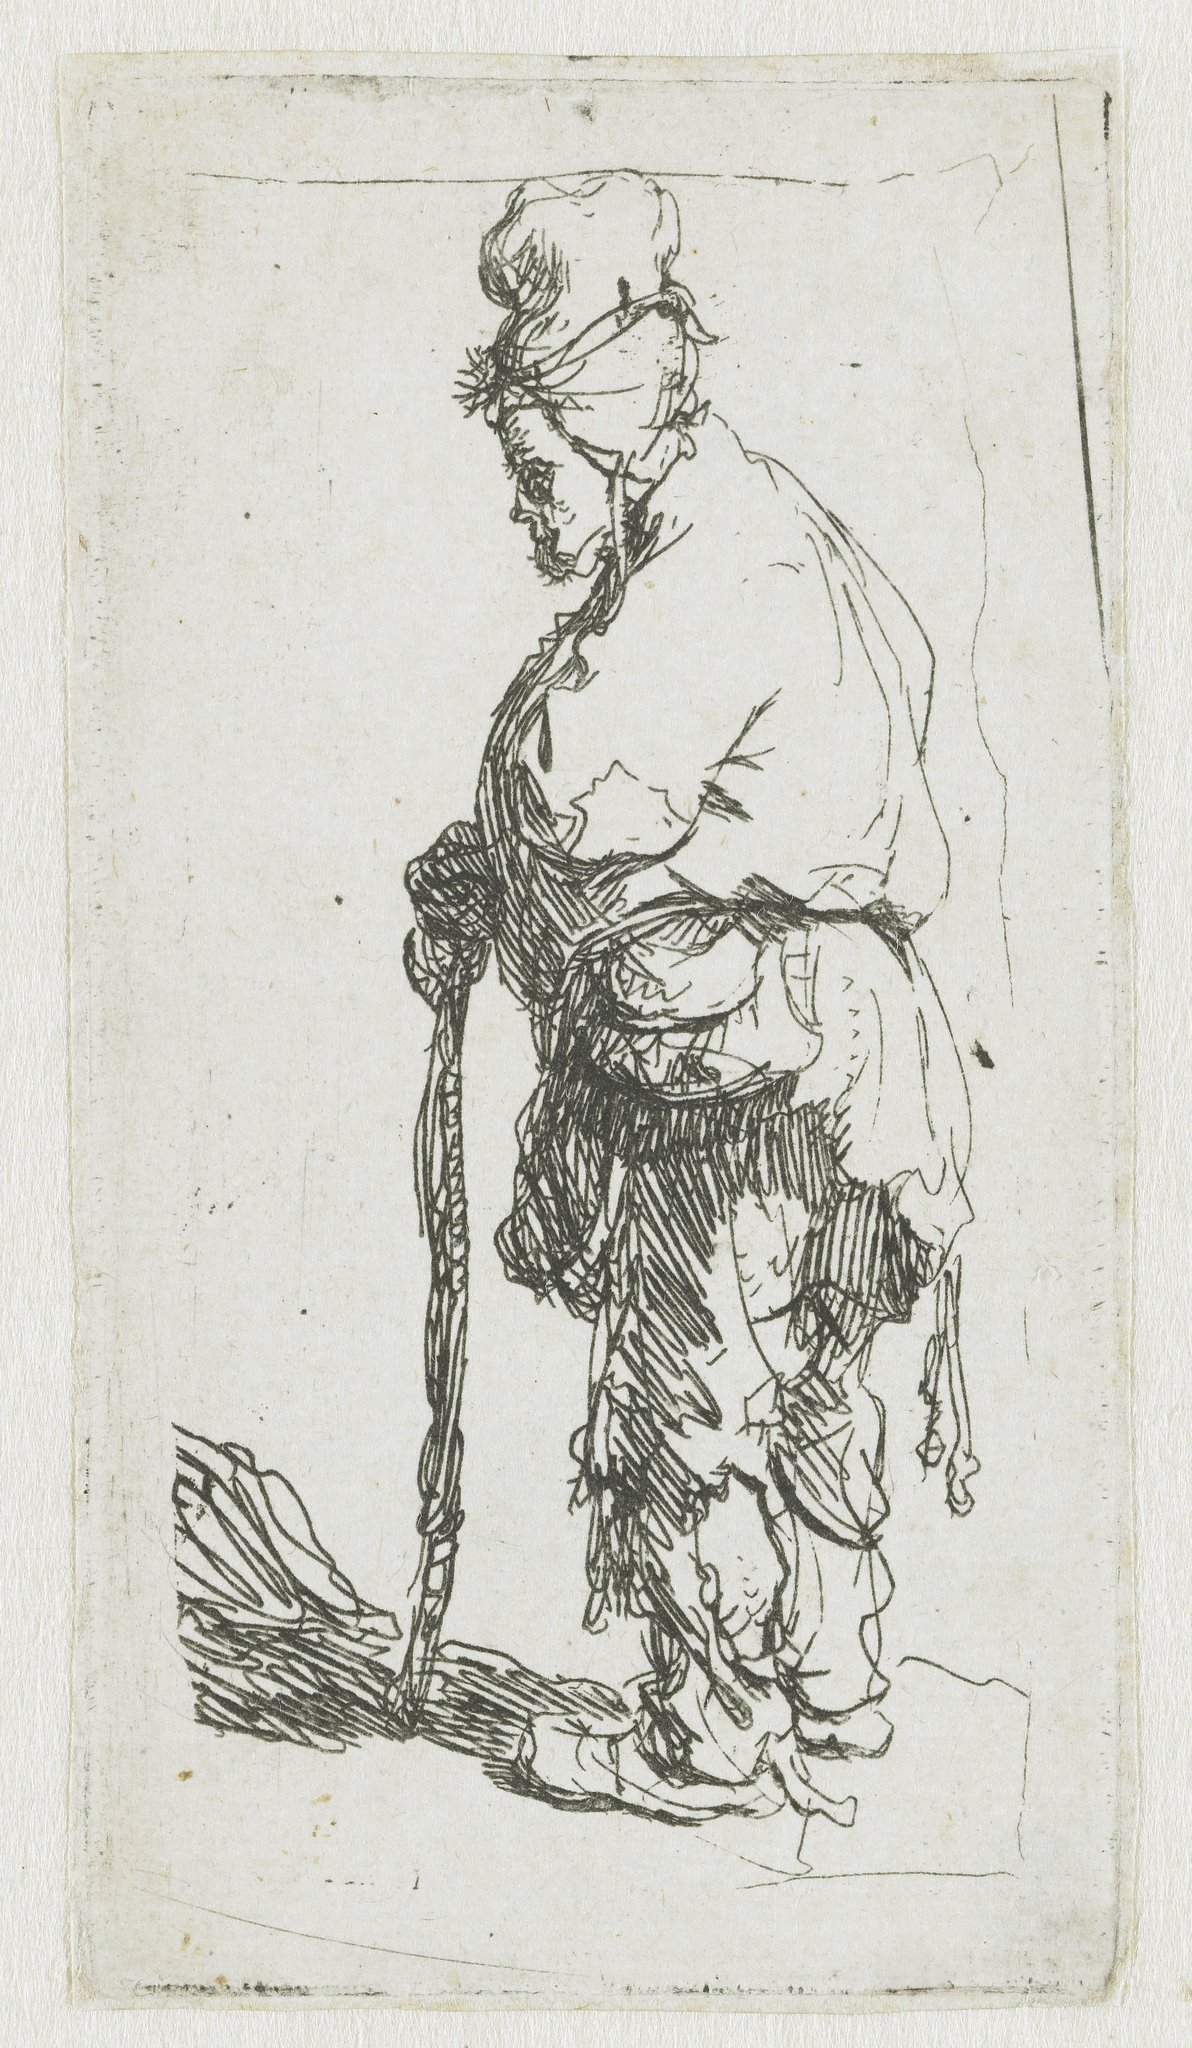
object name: print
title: Beggar leaning on a stick, facing left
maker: rembrandt van rijn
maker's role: draughtsman, painter, print maker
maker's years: 1606-1669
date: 1630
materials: paper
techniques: etching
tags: beggar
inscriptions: collector's mark: Lugt 2228, collector's mark: Lugt 58